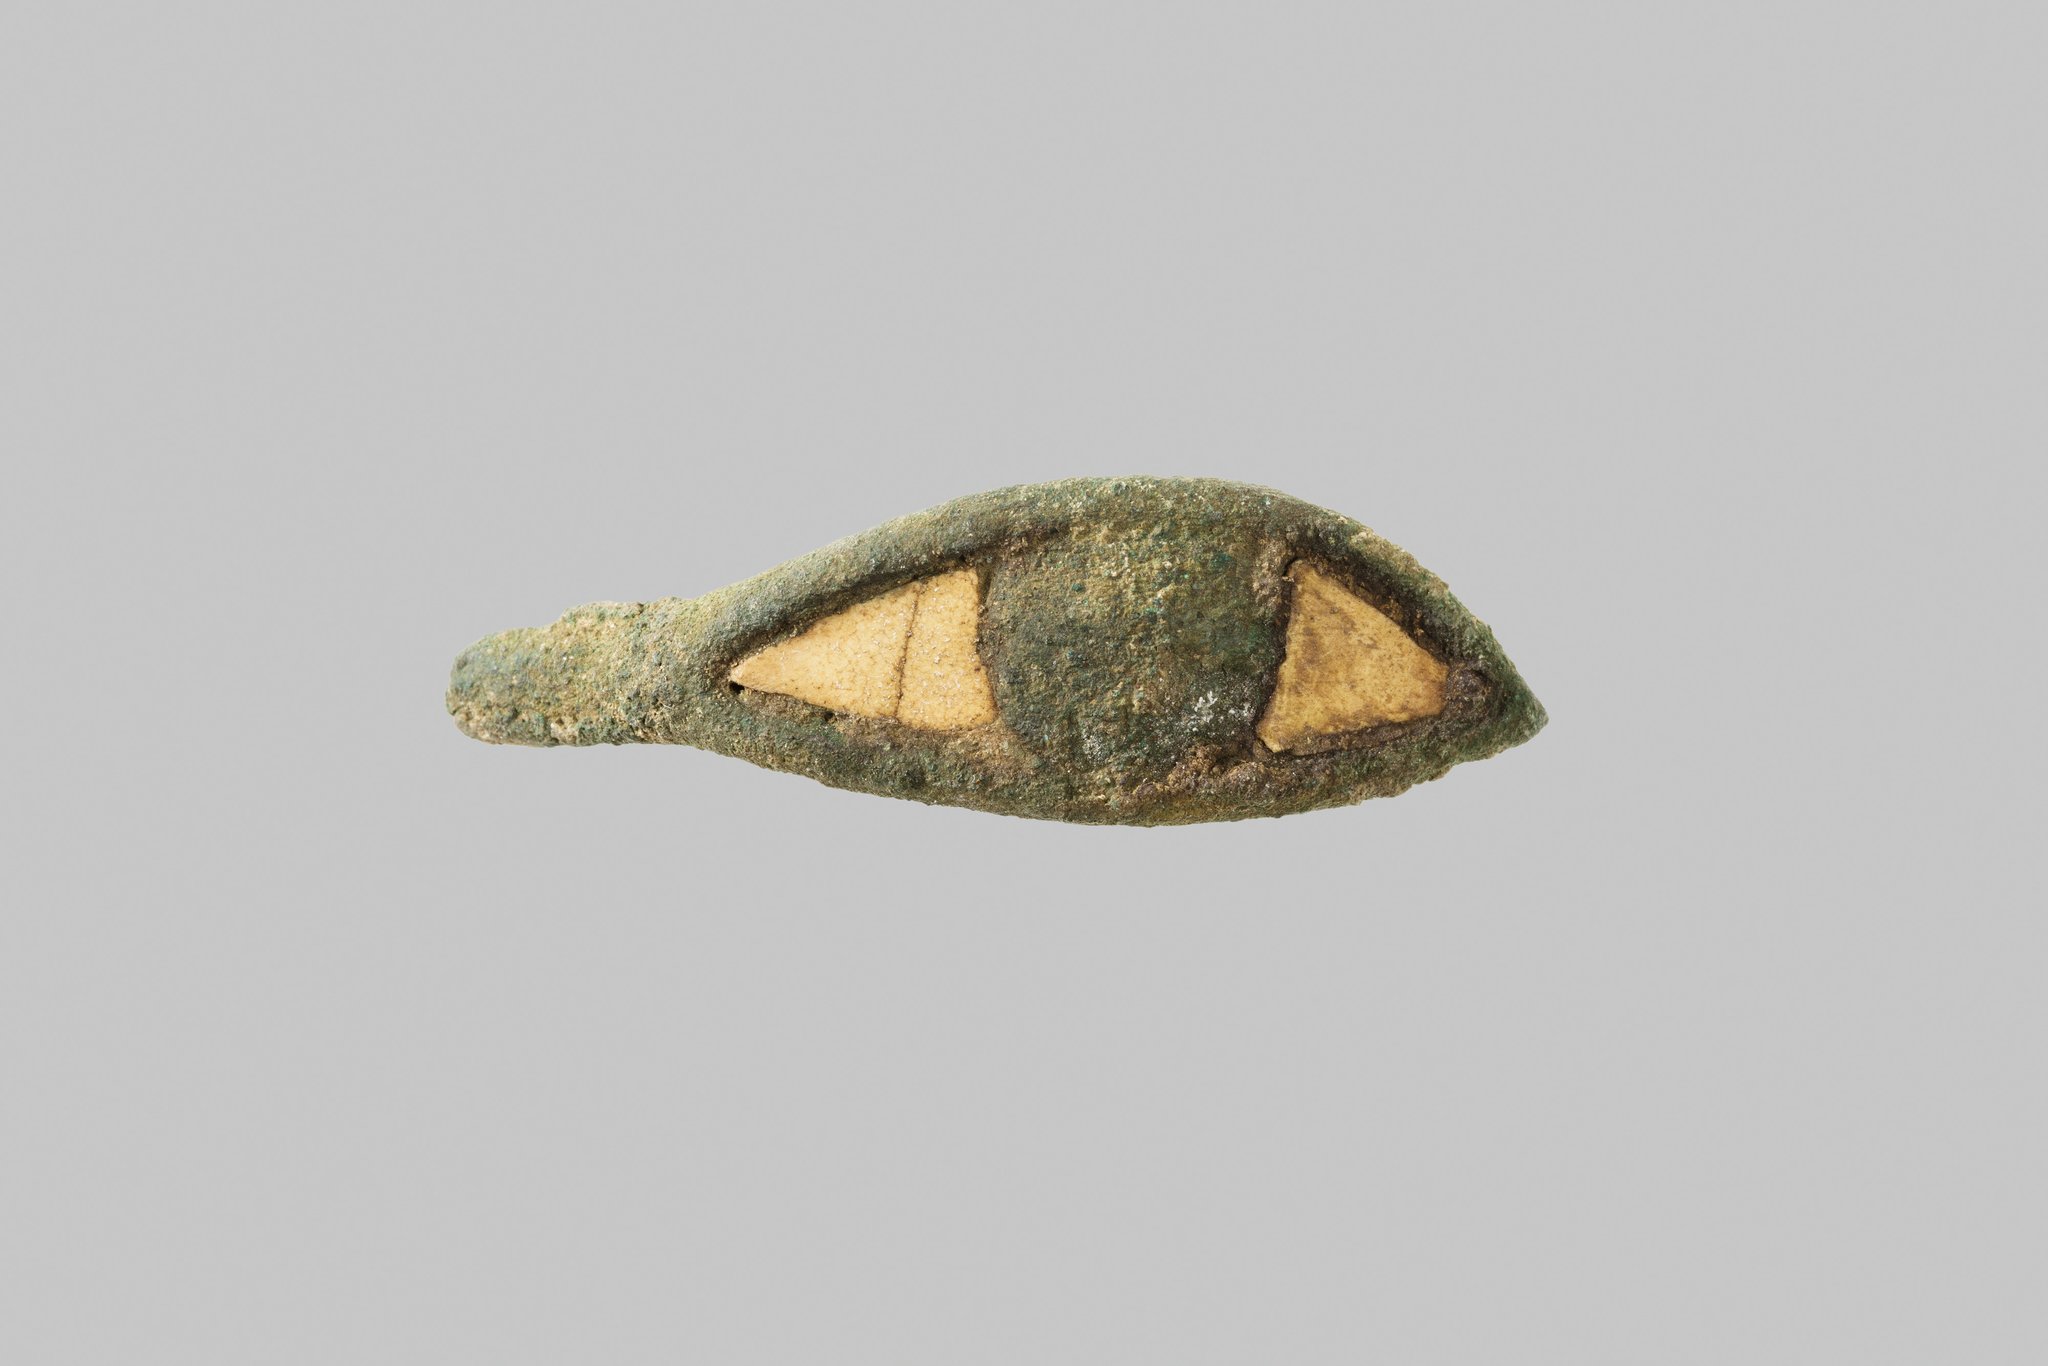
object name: statuette fragment, eye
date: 712-30 BCE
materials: bronze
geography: egypt